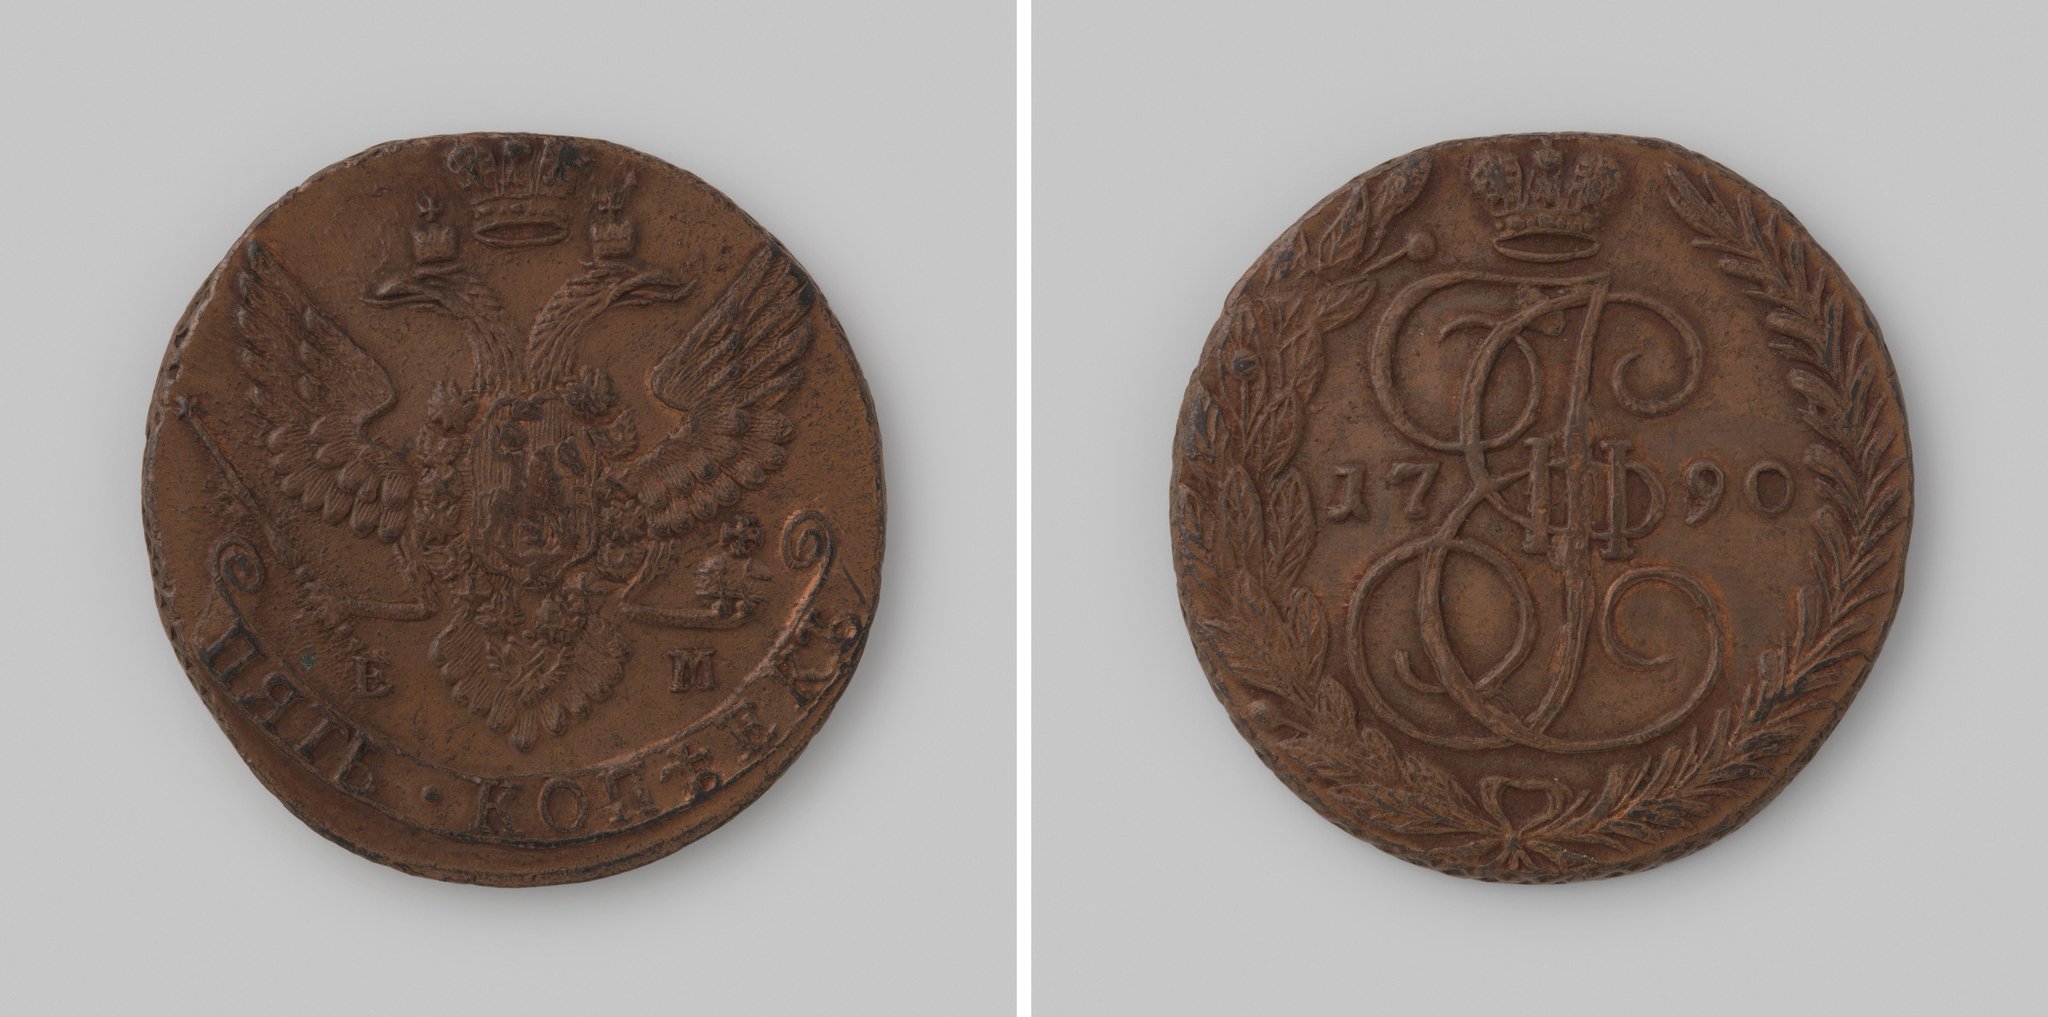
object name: coin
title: Rusland, Cahterina II, 5 kopeken, 1790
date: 1790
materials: copper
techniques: striking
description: Koperen munt. Voorzijde: dubbelkoppige gekroonde adelaar met gespreide vleugels, met op zijn borst door ridderorde omhangen wapenschild en met in zijn poten scepter en bol met daarop kruis. Boven de adelaar een kroon. Links en rechts onder de staart de letters E M [=Ekaterinenburg]. Onderaan op een banderol waarde-aanduiding. Keerzijde: binnen twee samengebonden takken tussen het jaartal gekroond monogram van de czarina. Kabelrand.